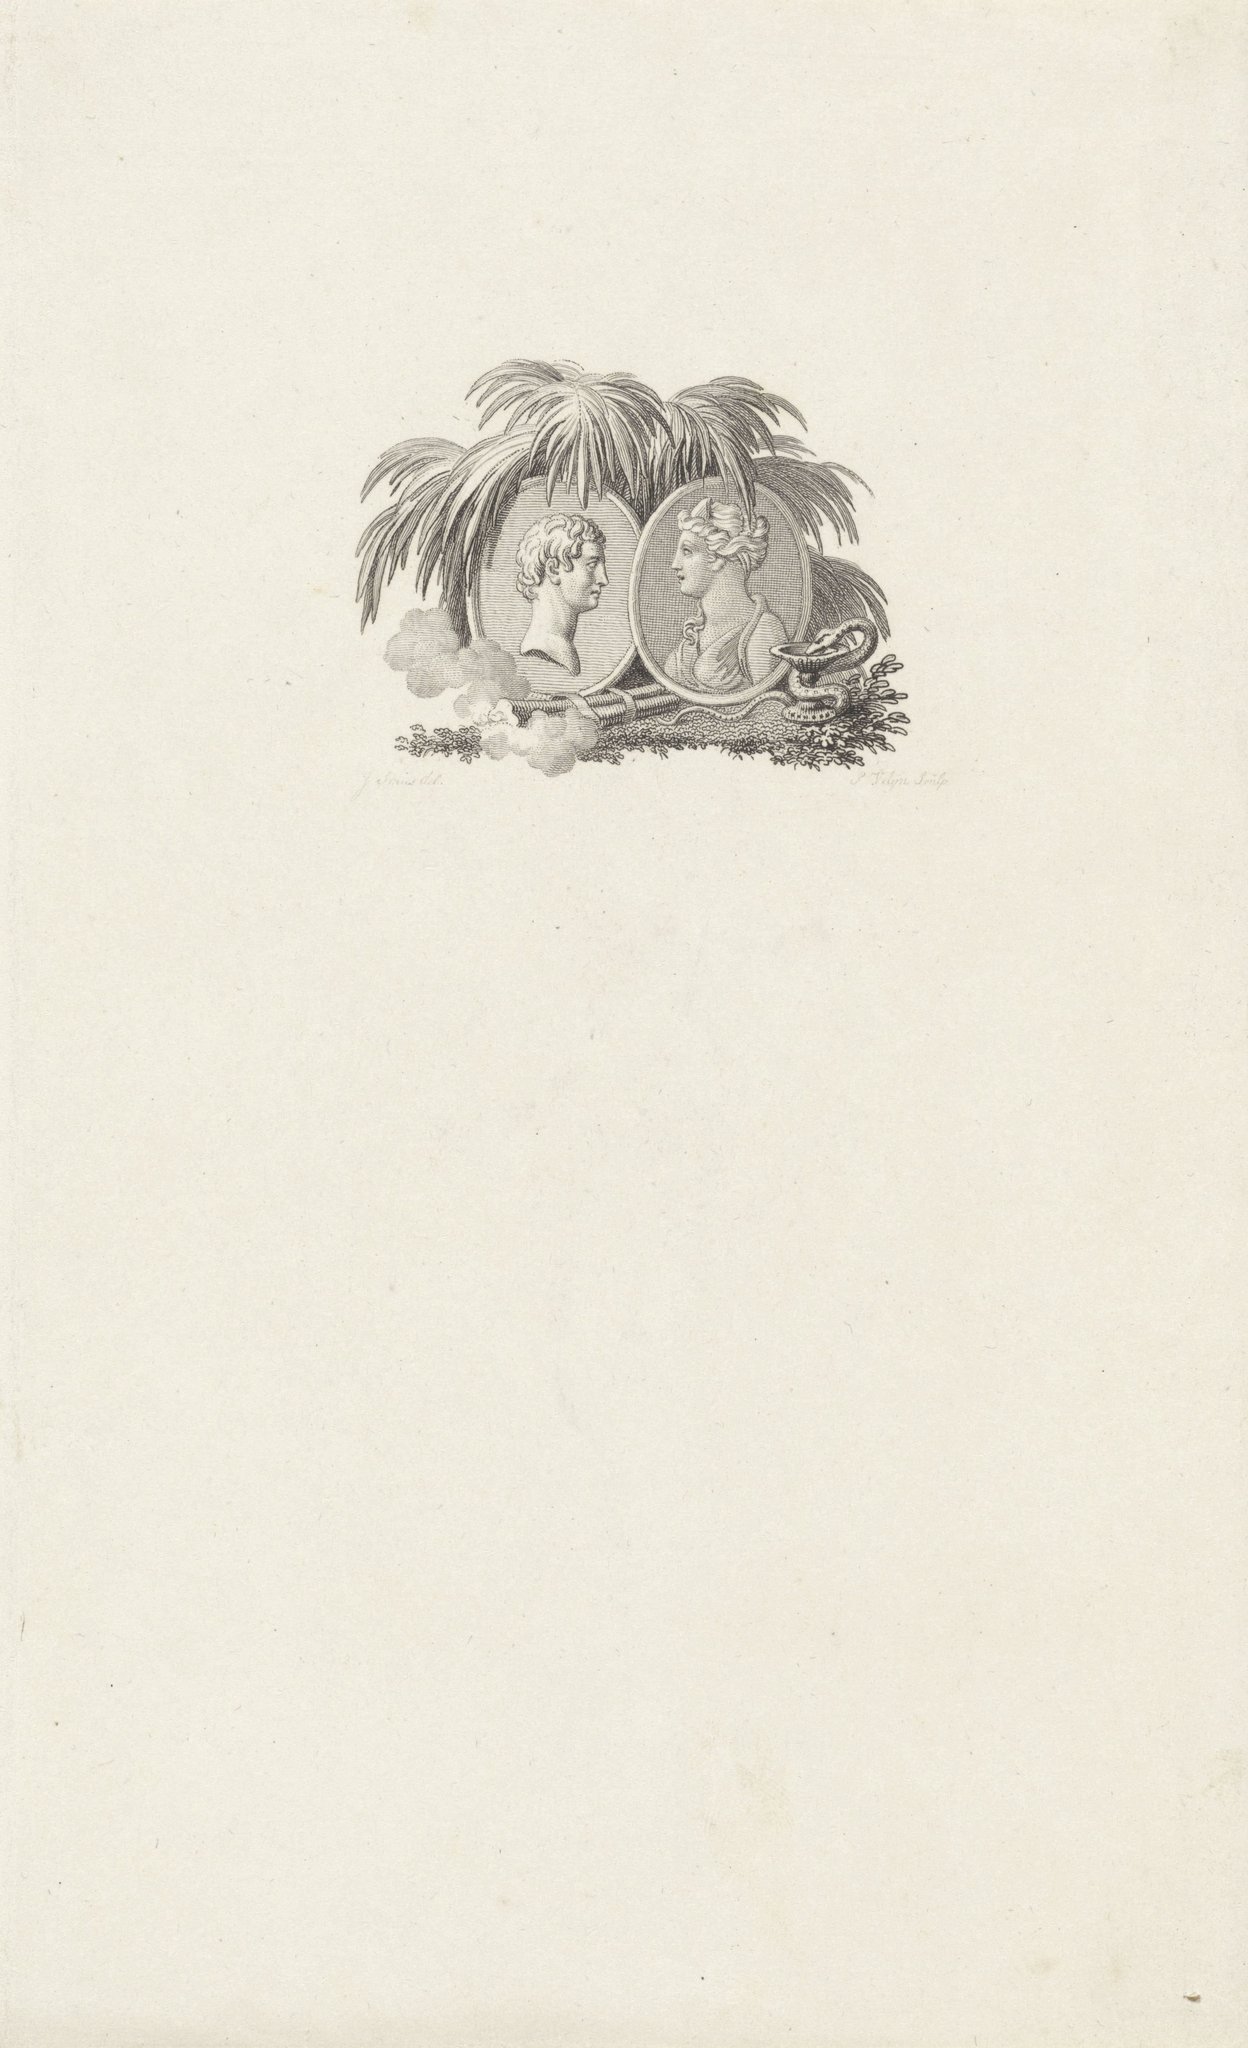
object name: print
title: Twee Romeinse portretmedaillons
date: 1797-1836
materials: paper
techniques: engraving, etching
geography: netherlands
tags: torch (+ extinguishing; extinguished light, lamp, candle), piece of sculpture, reproduction of a piece of sculpture, snakes (+ animals used symbolically)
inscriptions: collector's mark: Lugt 2228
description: Twee Romeinse portretmedaillons onder gebladerte. Rechtsvoor een slang om een drinkbeker gekronkeld en tussen de portretten een gedoofde fakkel.